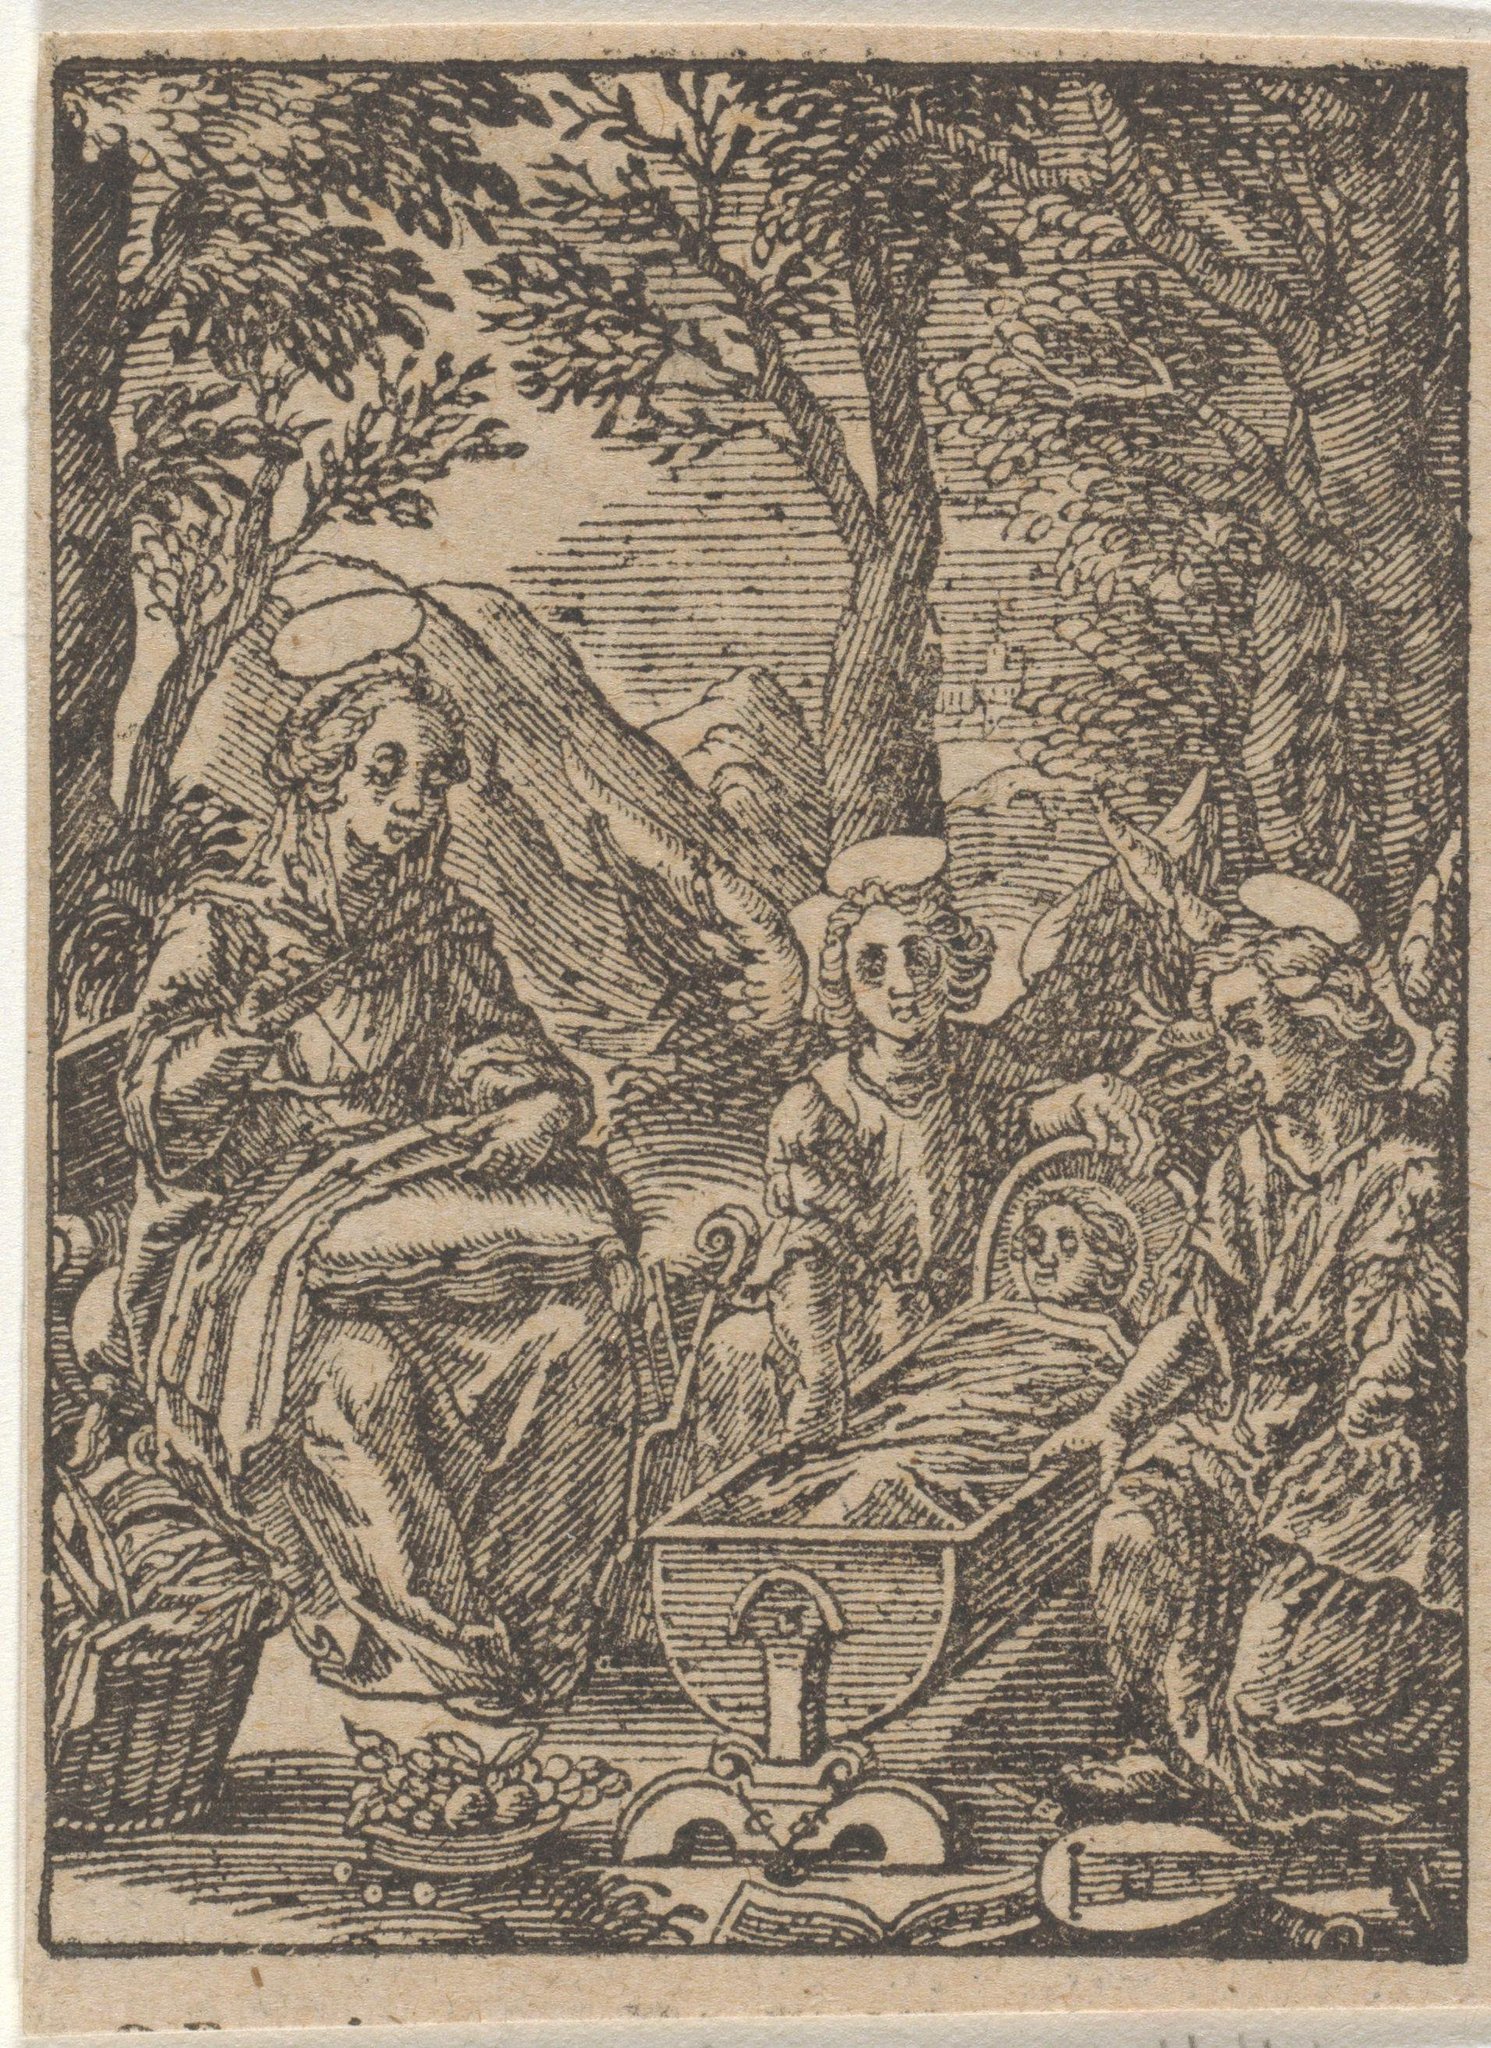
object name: print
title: Jeugd van Christus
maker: christoffel van sichem (ii)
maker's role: print maker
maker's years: 1581-1658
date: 1617-1658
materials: paper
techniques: woodcut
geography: amsterdam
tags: cradle, crib, angels, household occupations of mary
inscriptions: collector's mark: Lugt 240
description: Landschap met het Christuskind dat in zijn wieg ligt te slapen. Twee engelen waken over hem. Maria zit naast de wieg en borduurt.